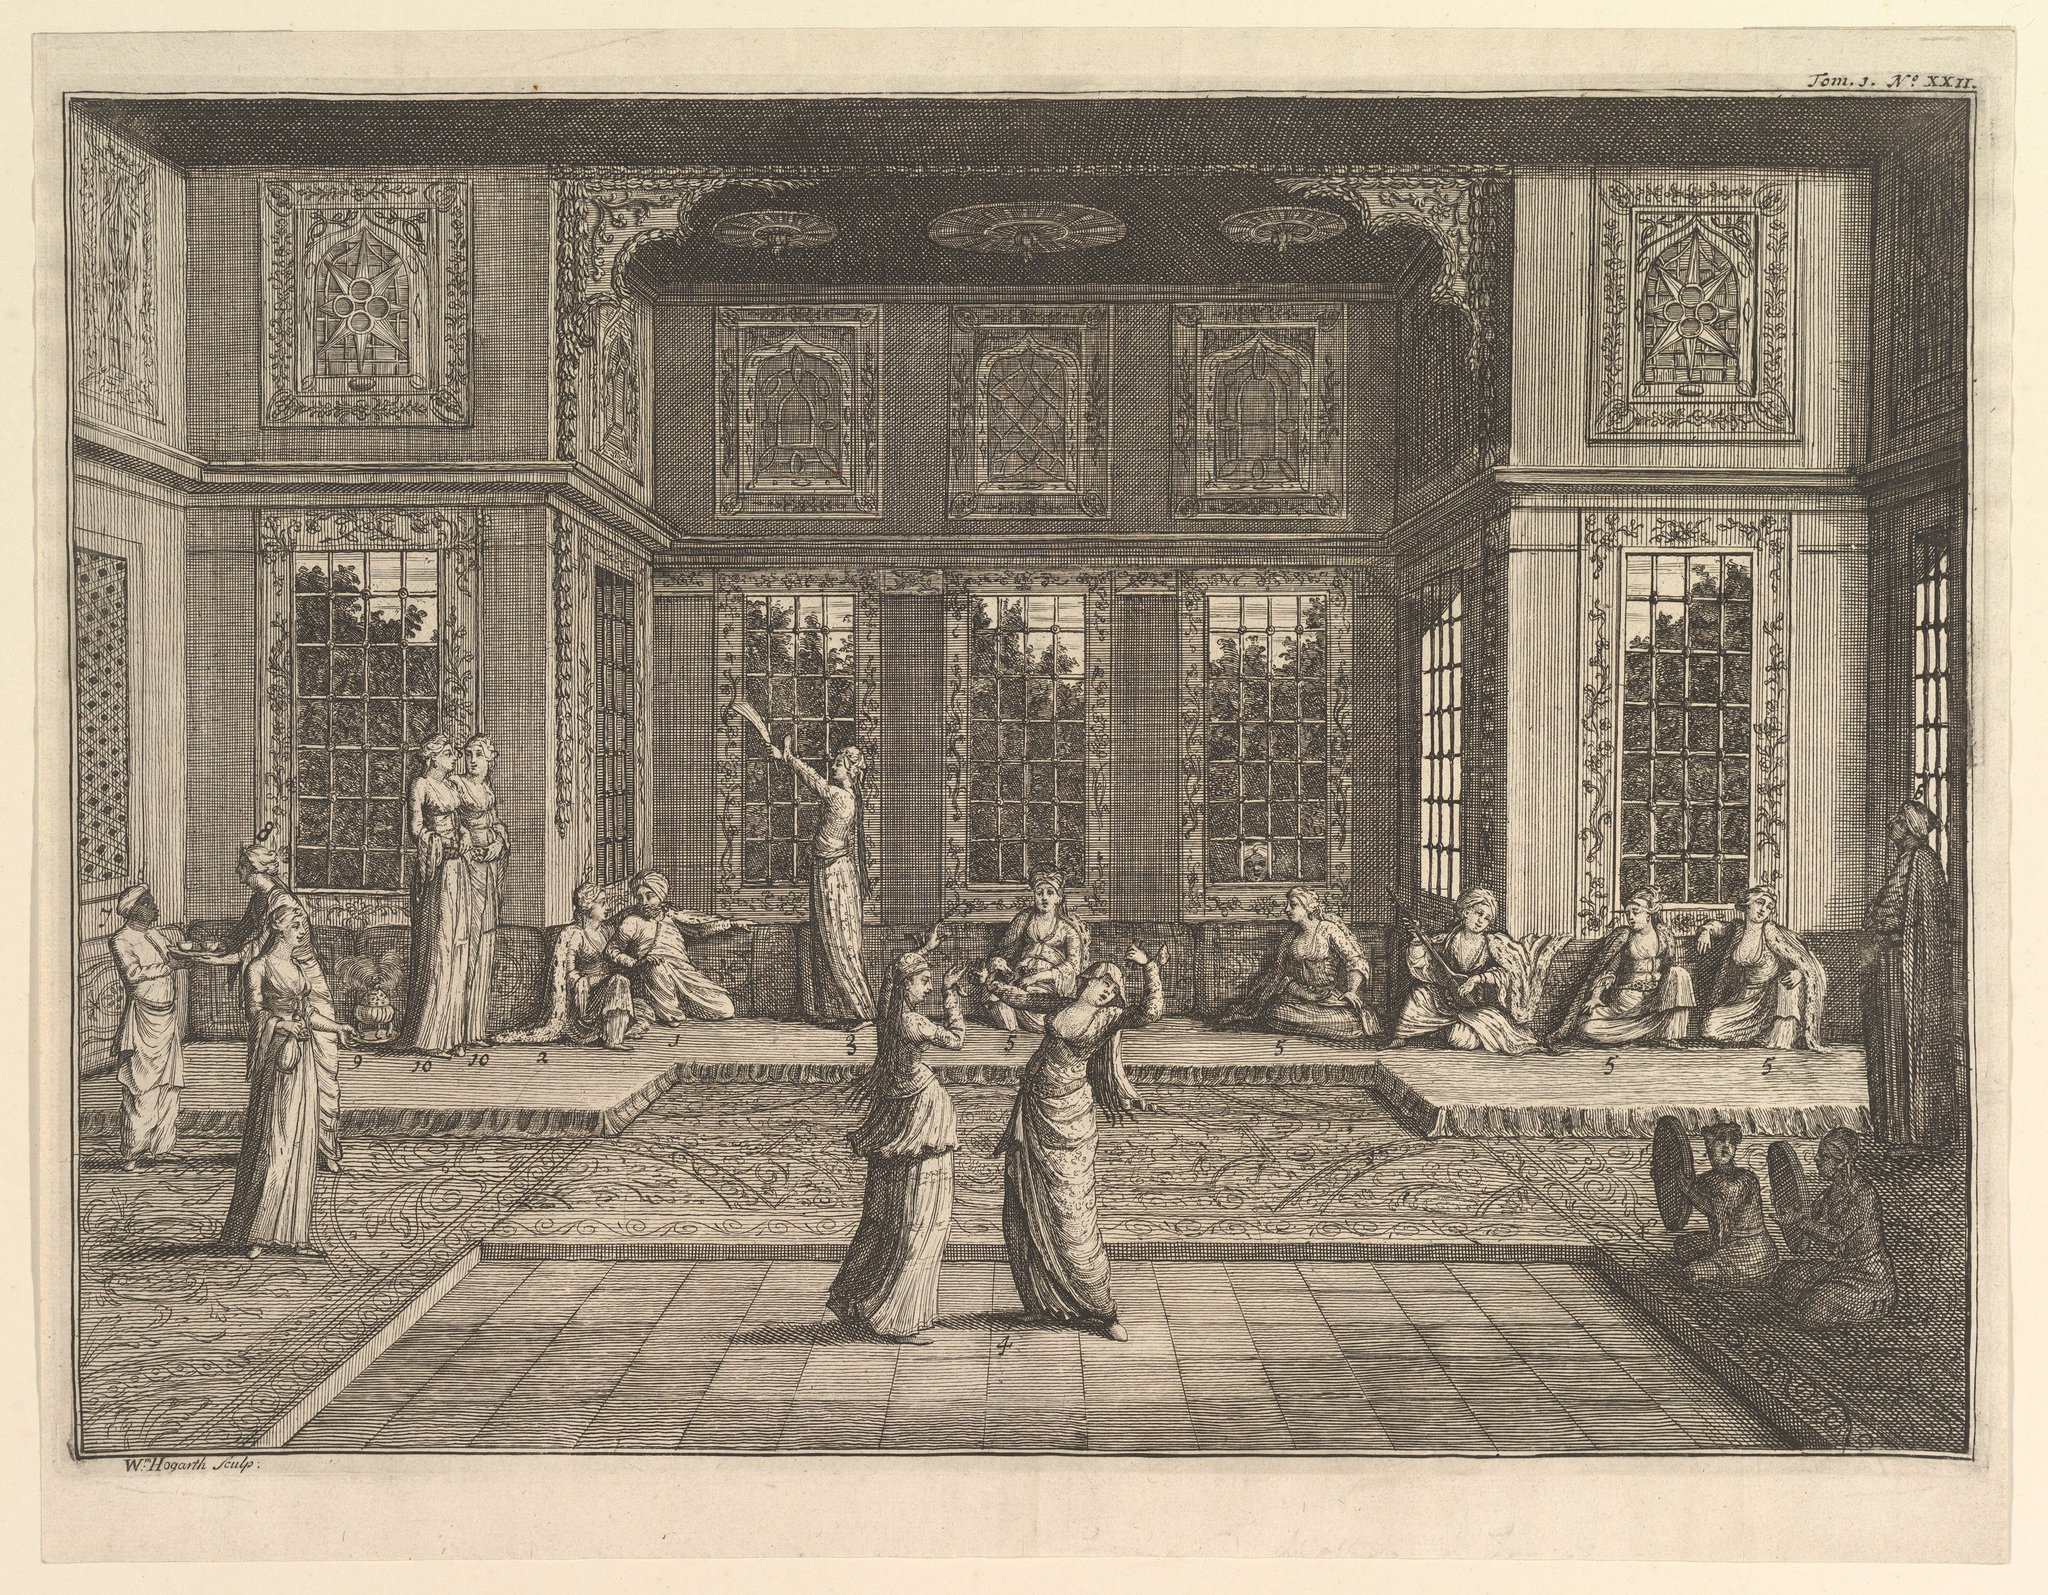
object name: print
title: The Seraglio (Aubry de La Mottraye, Travels throughout Europe, Asia and into Part of Africa..., London, 1724, vol. I, pl. 18)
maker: william hogarth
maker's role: artist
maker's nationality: british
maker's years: 1697-1764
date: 1723-1724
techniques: engraving, etching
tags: musical instruments,men,women,dancing